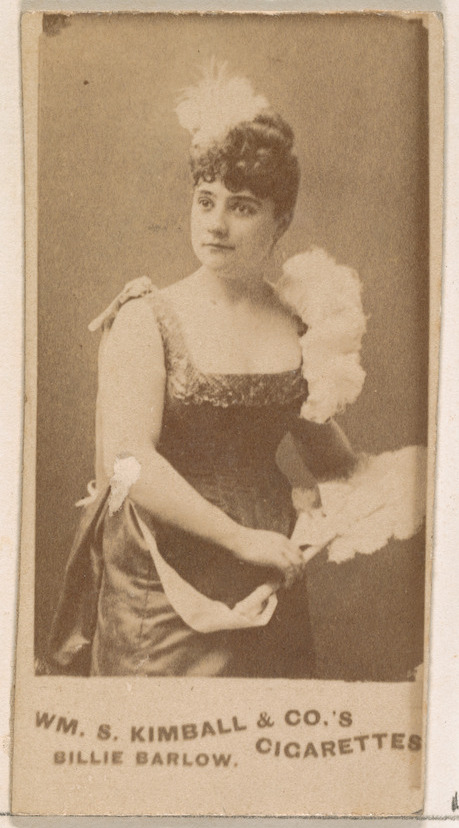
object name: photograph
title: Billie Barlow, from the Actresses series (N203) issued by Wm. S. Kimball & Co.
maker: william s. kimball & company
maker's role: publisher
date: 1889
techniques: color lithograph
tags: portraits,women,actresses